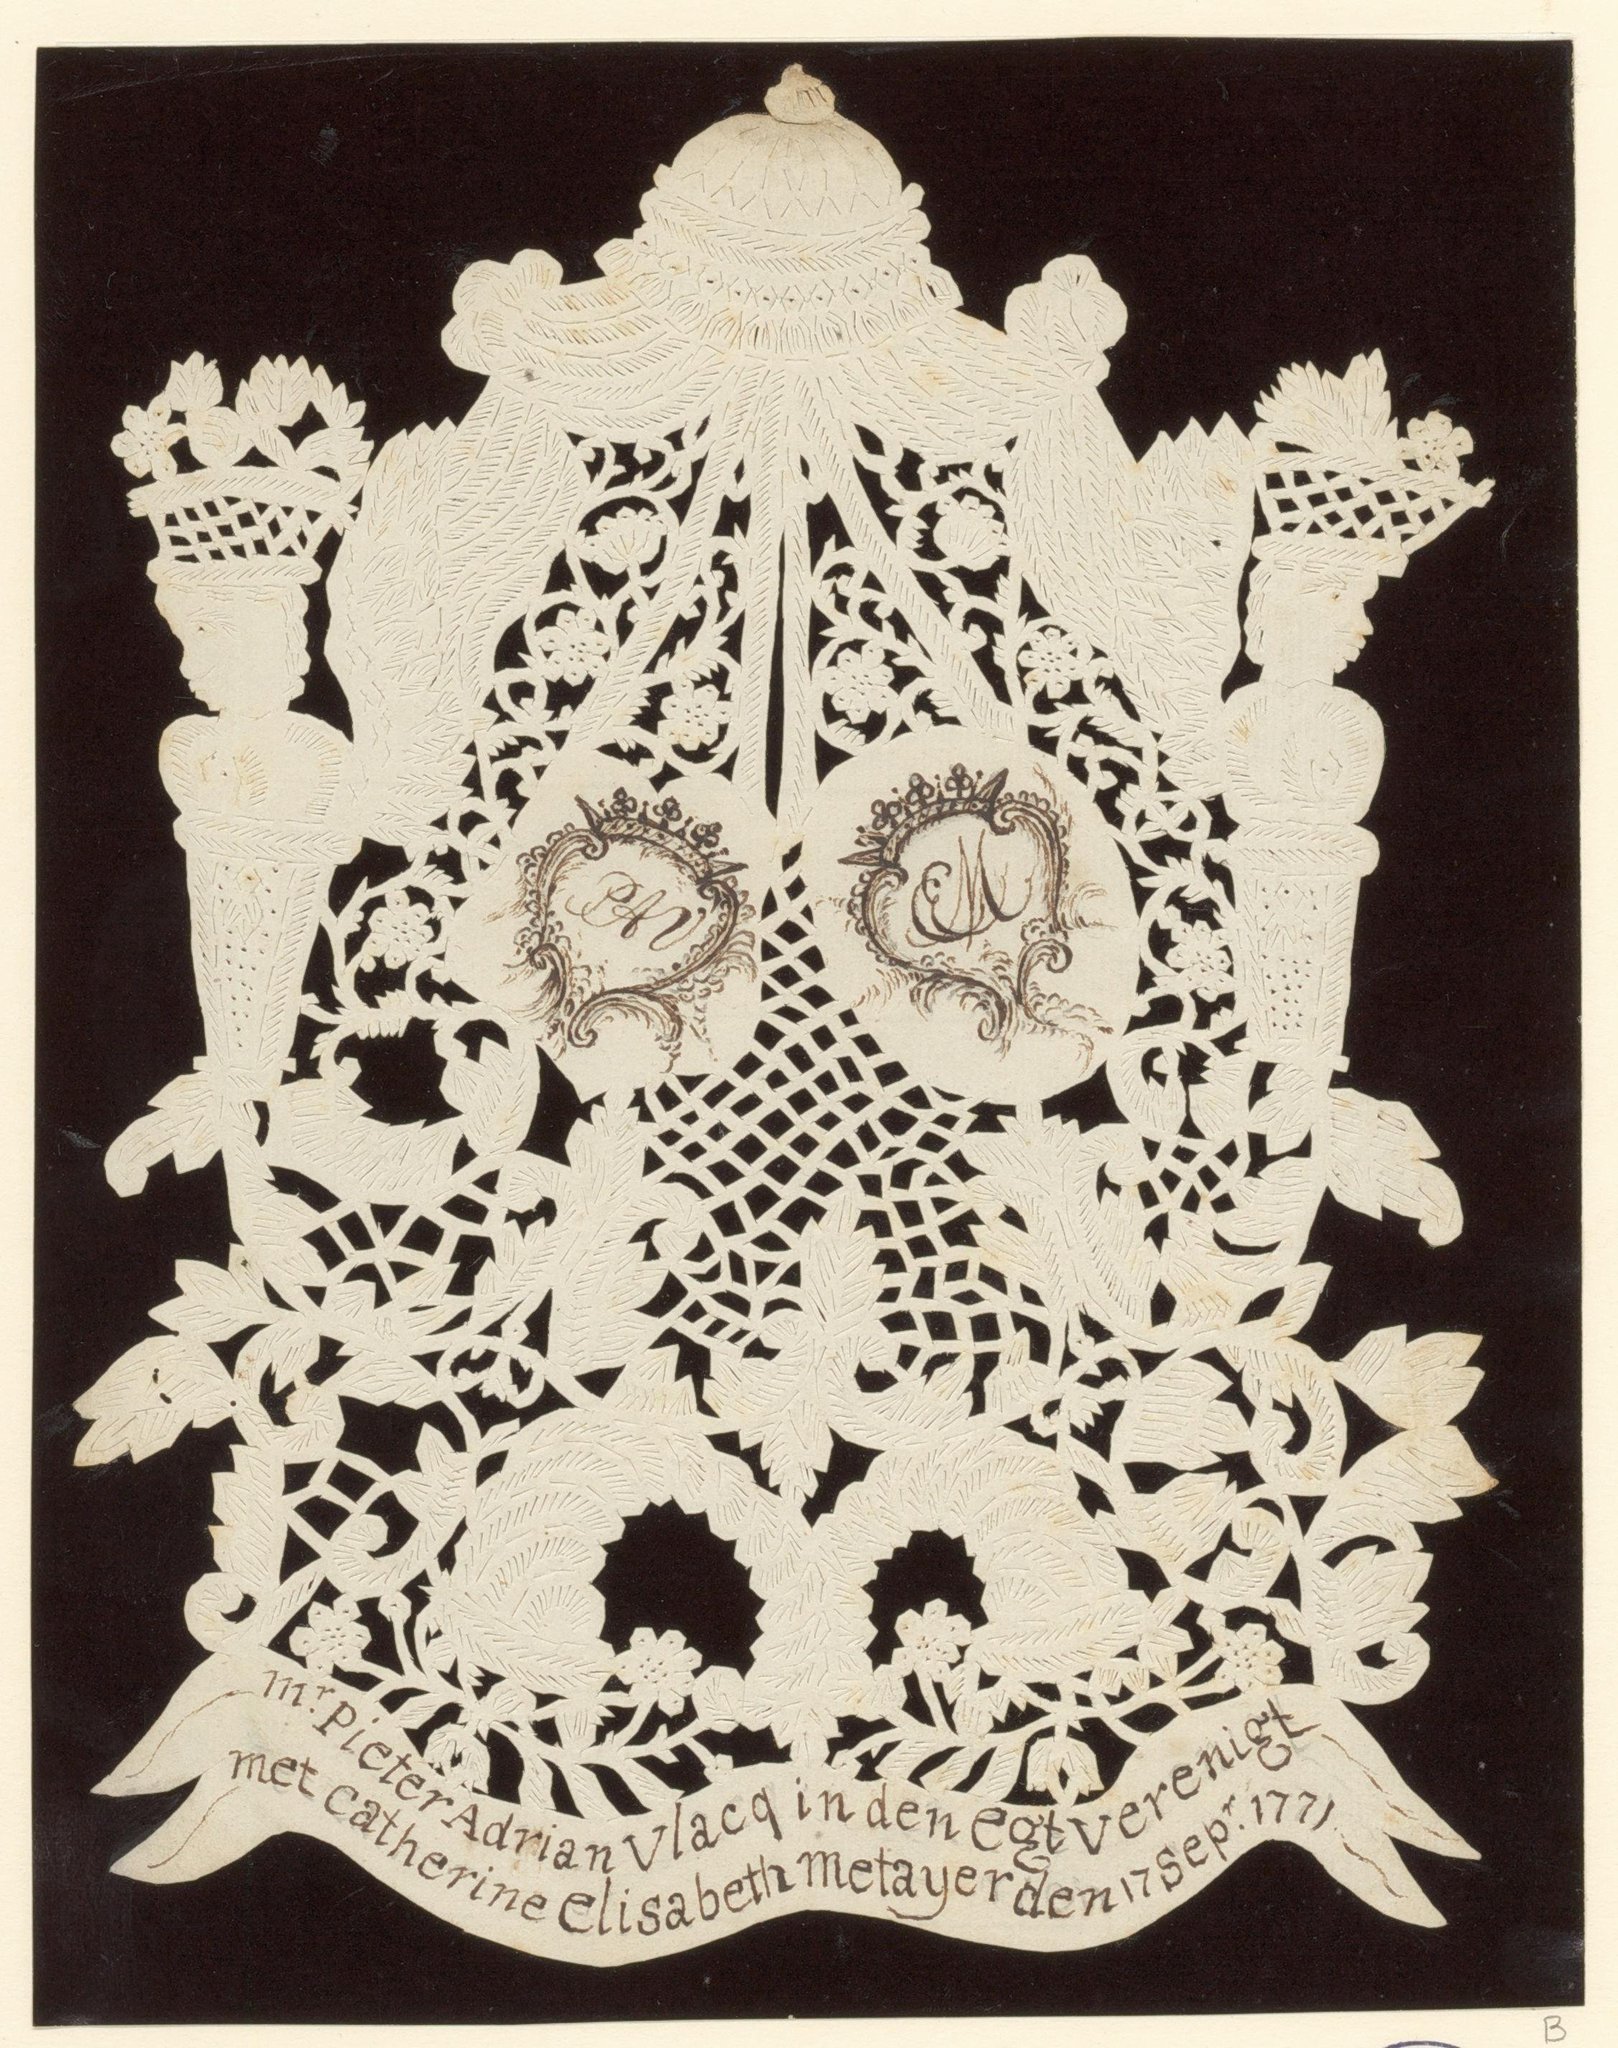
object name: cut paper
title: Huwelijksknipsel met twee monogrammen van Pieter Adrian Vlacq en Catherine Elisabeth Metayer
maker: Anonymous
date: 1771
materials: ink, paper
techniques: pen, snipping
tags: rotterdam, catharina elisabeth metayer, flowers, marriage, married couple, 'matrimonium'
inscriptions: stamp, collector's mark: Lugt 1641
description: Plaatsaanduiding voor huwelijksmaaltijd met twee monogrammen, een baldakijn en twee bustes op sokkels. In het midden in inkt twee wapenschilden aan linten met twee gekroonde medaillons, waarin links PAV en rechts CEM. Links en rechts twee gevleugelde kariatiden met bloemenmanden op het hoofd. De onderste helft bestaat uit een rasterwerk en florale motievenOnderaan de tekst: mr. Pieter Adrian Vlacq in den egt verenigt met Catharina Elisabeth Metayer den 17 Sepr. 1771. Onderwerpsrubrieken binnen de Atlas Zeden en Gewoonten: Schoone kunsten, Knipkunst.